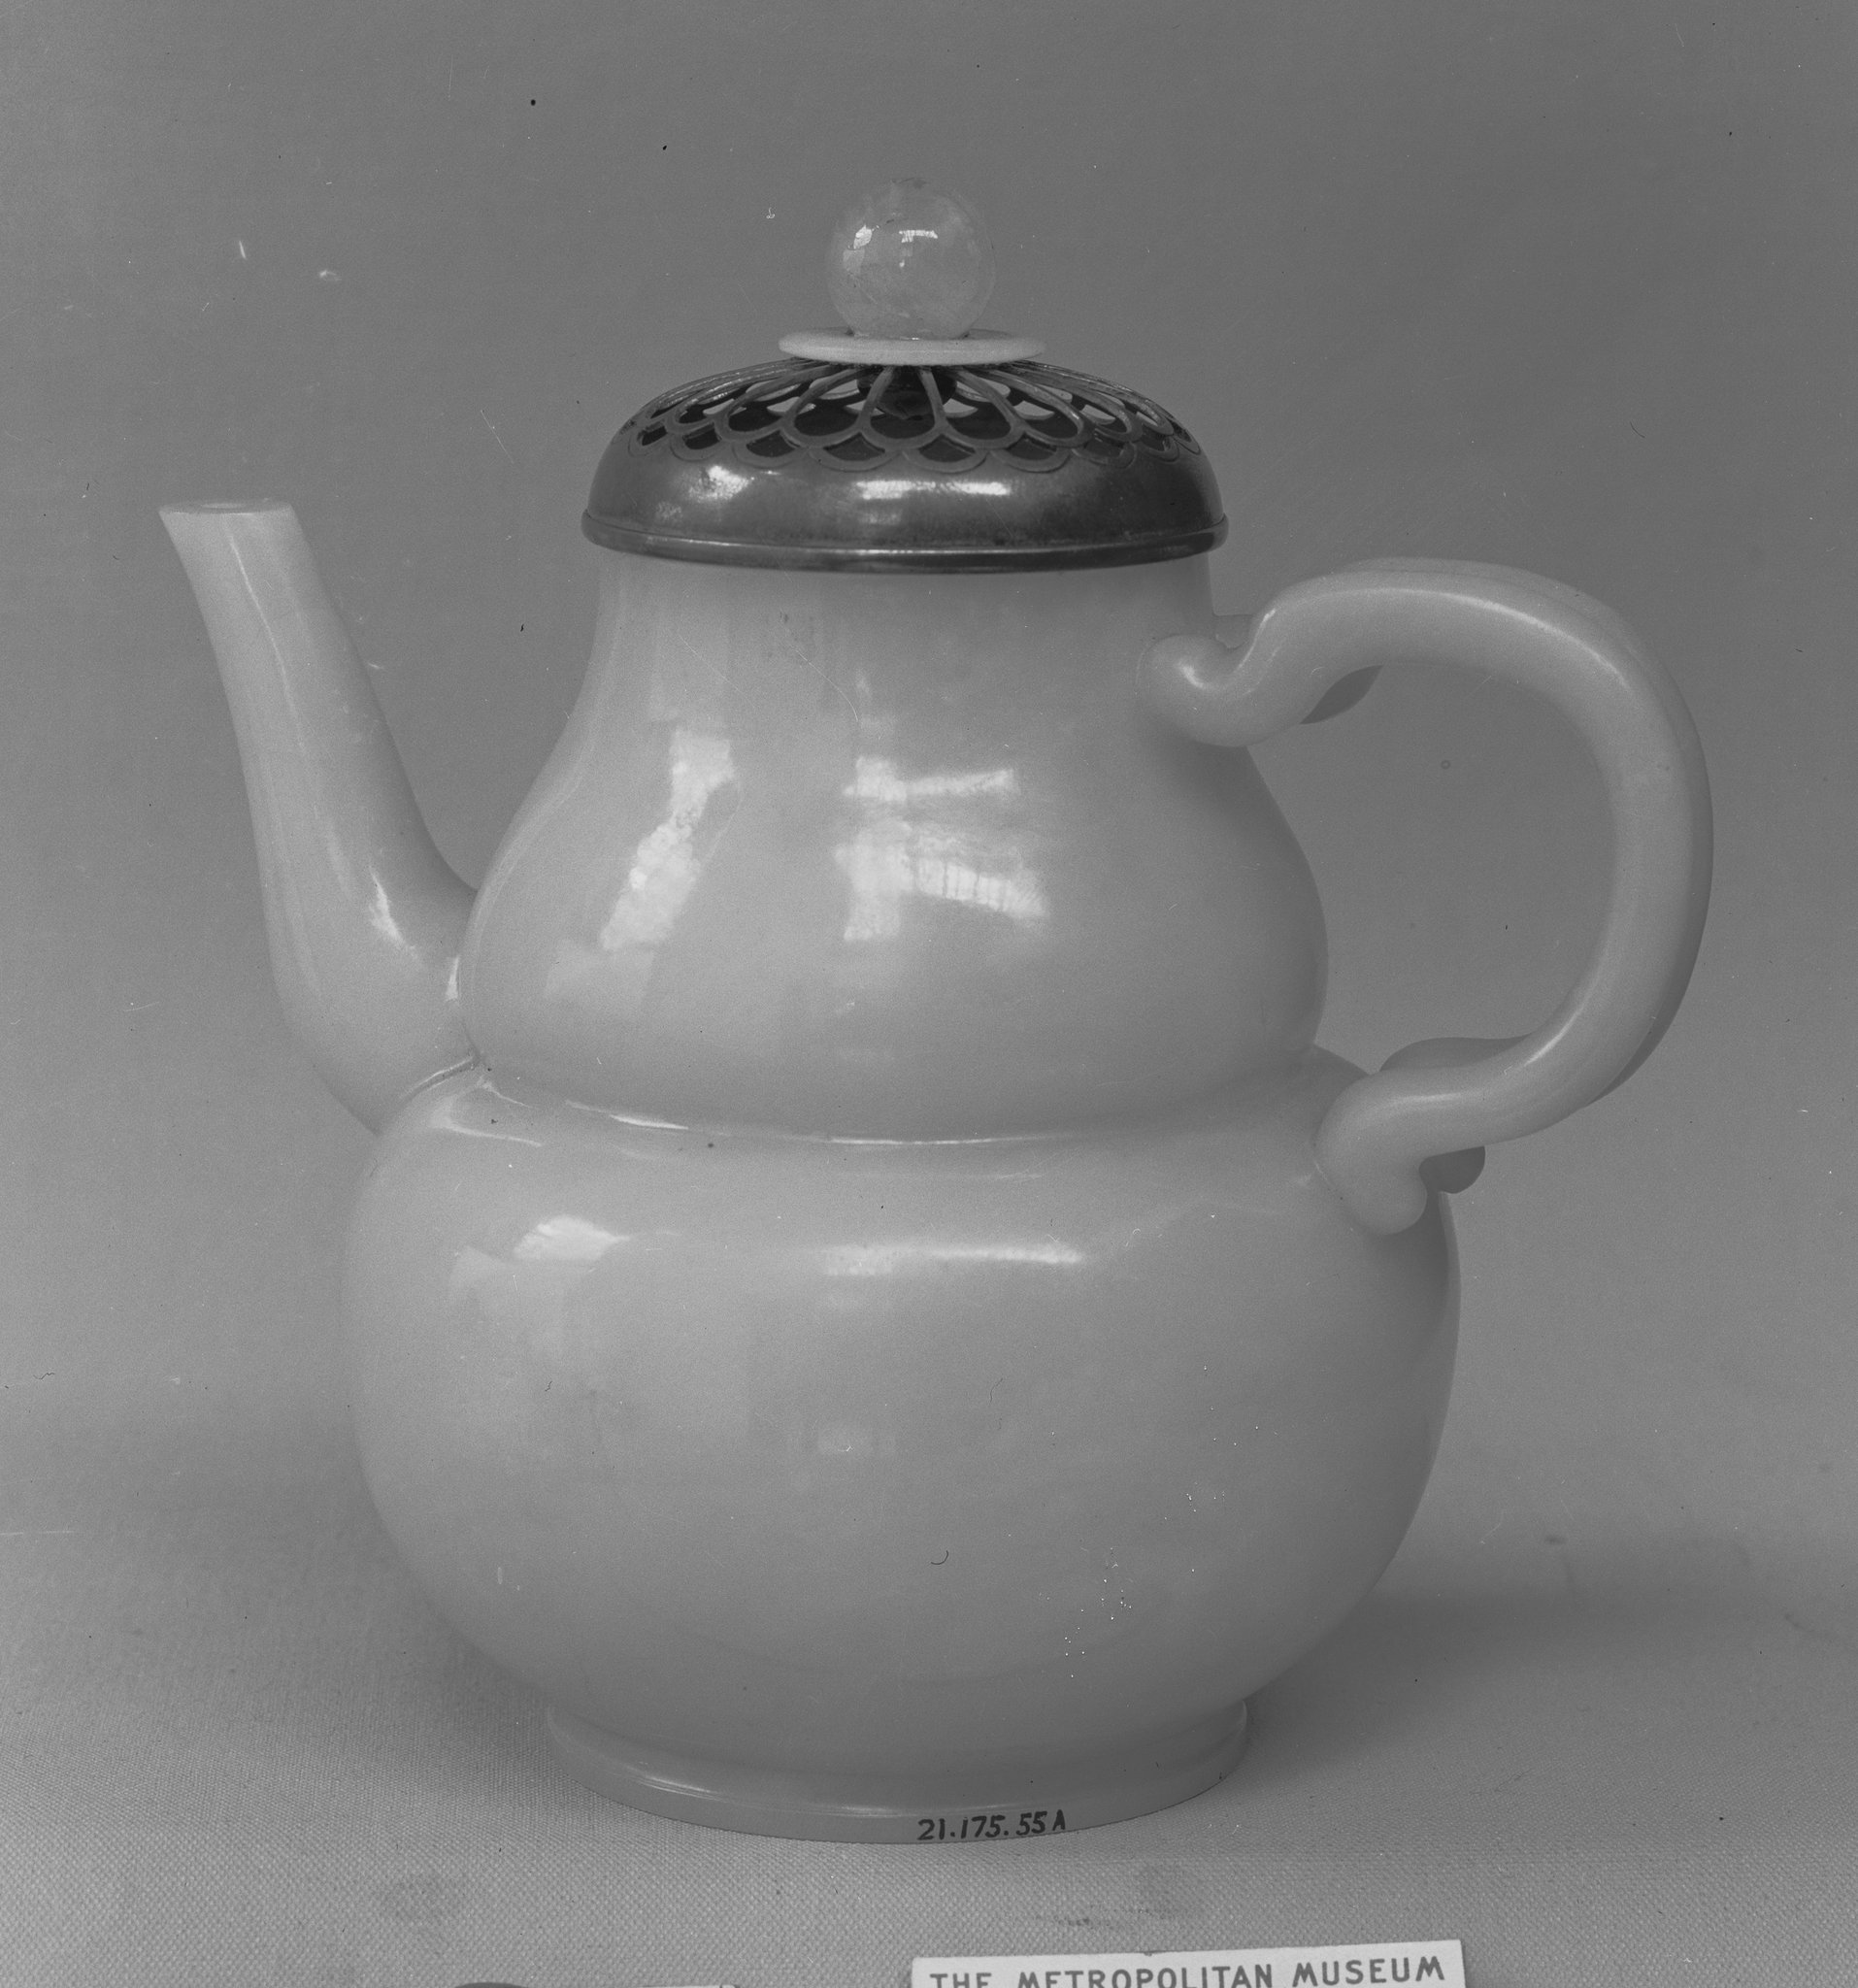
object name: wine pot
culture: chinese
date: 1736-1795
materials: metal, jade